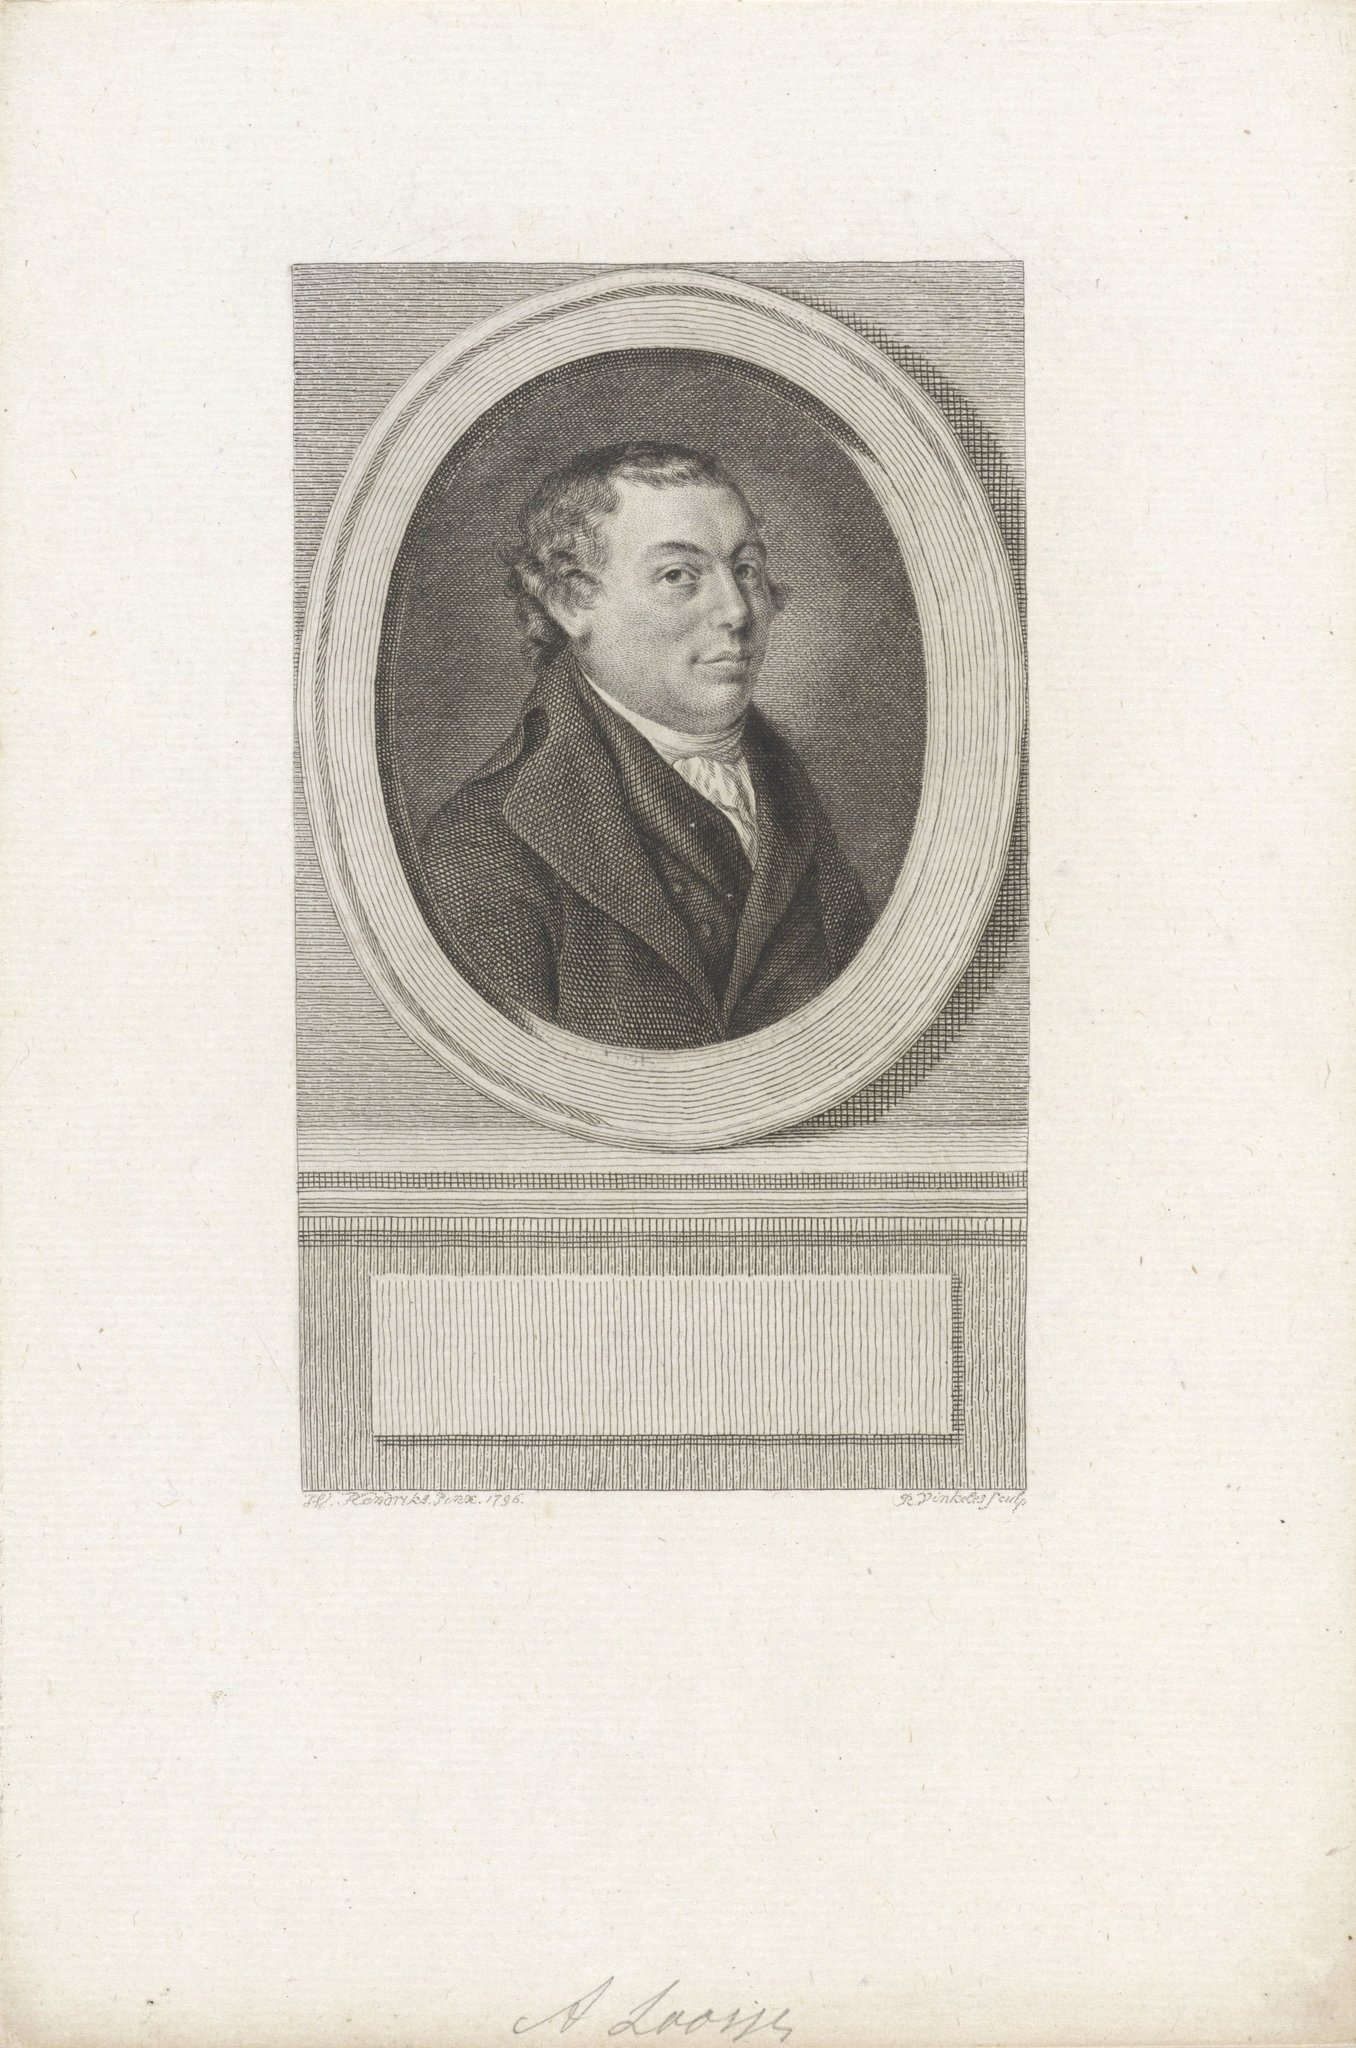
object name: print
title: Portret van Adriaan Pietersz. Loosjes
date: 1796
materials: paper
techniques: engraving, etching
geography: amsterdam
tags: haarlem, publisher, adriaan pietersz. loosjes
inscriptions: collector's mark: Lugt 2228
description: Latere staat prent ook gebruikt als boekillustratie in: Wagenaar, Jan. Vaderlandsche historie, (...) ten vervolge van Wagenaars Vaderlandsche historie. Dl. 1-43. Amsterdam: Johannes Allart, 1786-1809.